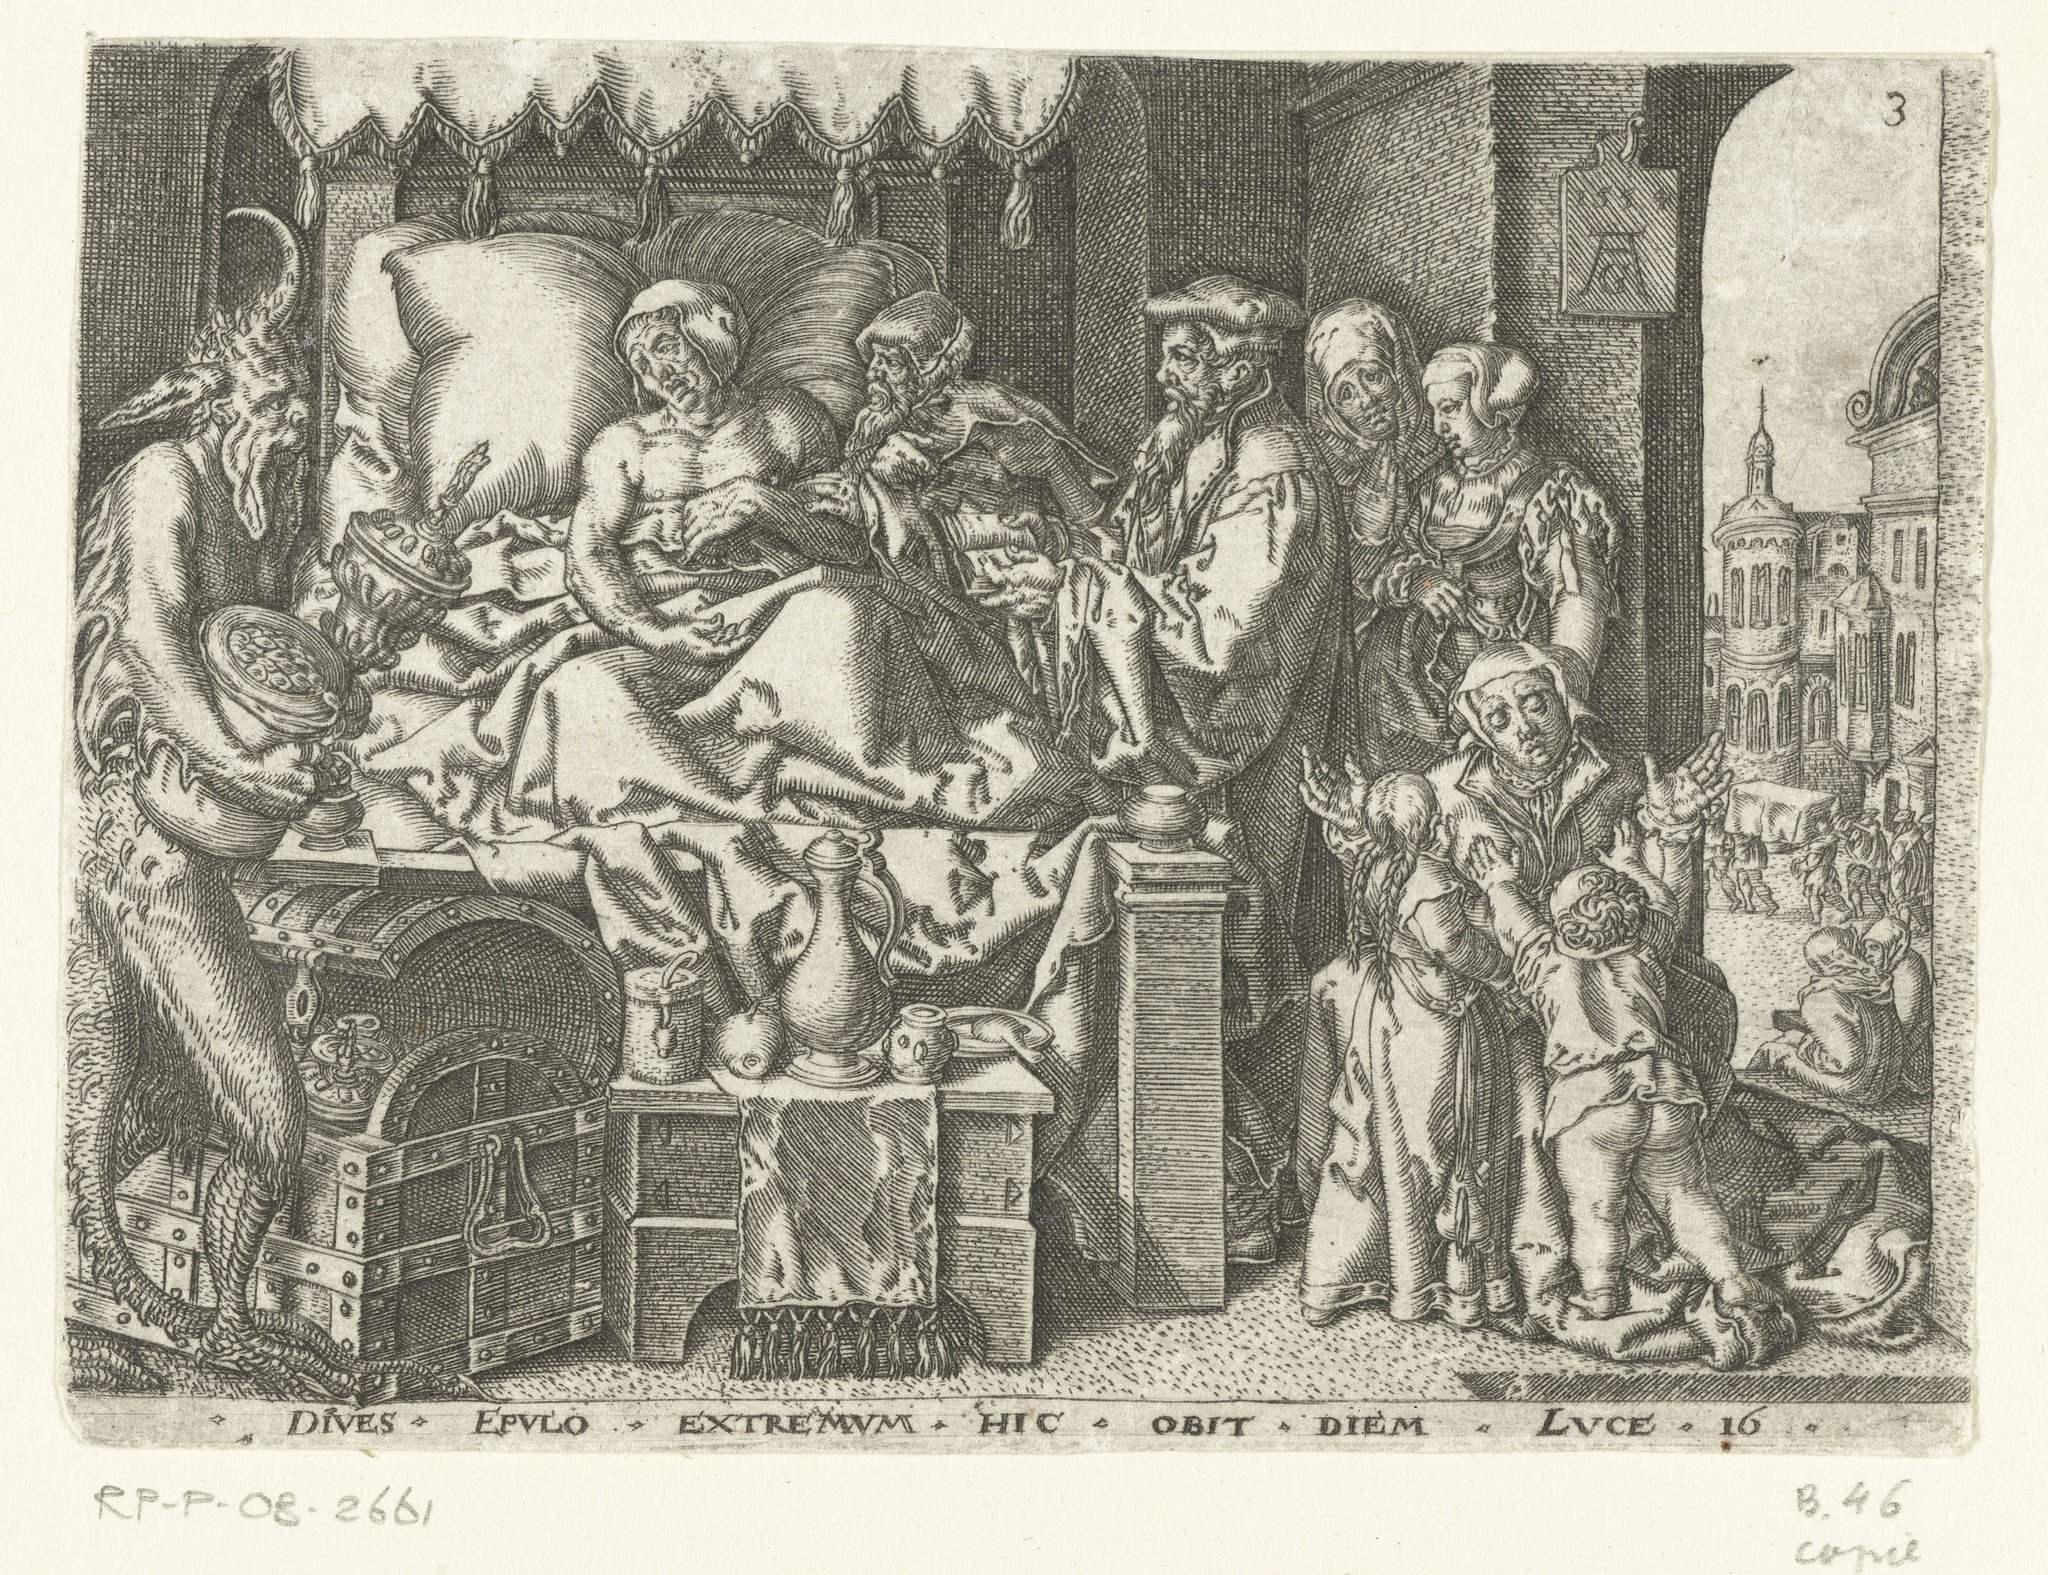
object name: print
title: De rijke man op zijn sterfbed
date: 1554-1610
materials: paper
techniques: engraving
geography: germany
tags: dives dies; his soul is brought into hell by devils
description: De rijke man ligt in zijn bed op sterven, aan zijn bedrand een aantal mensen. Aan het voeteneinde de duivel die zijn aardse rijkdommen vasthoudt. Onder de voorstelling de tekst: Dives epulo extremum hic obit diem Luce 16. Derde prent uit een serie van vijf kopieën .